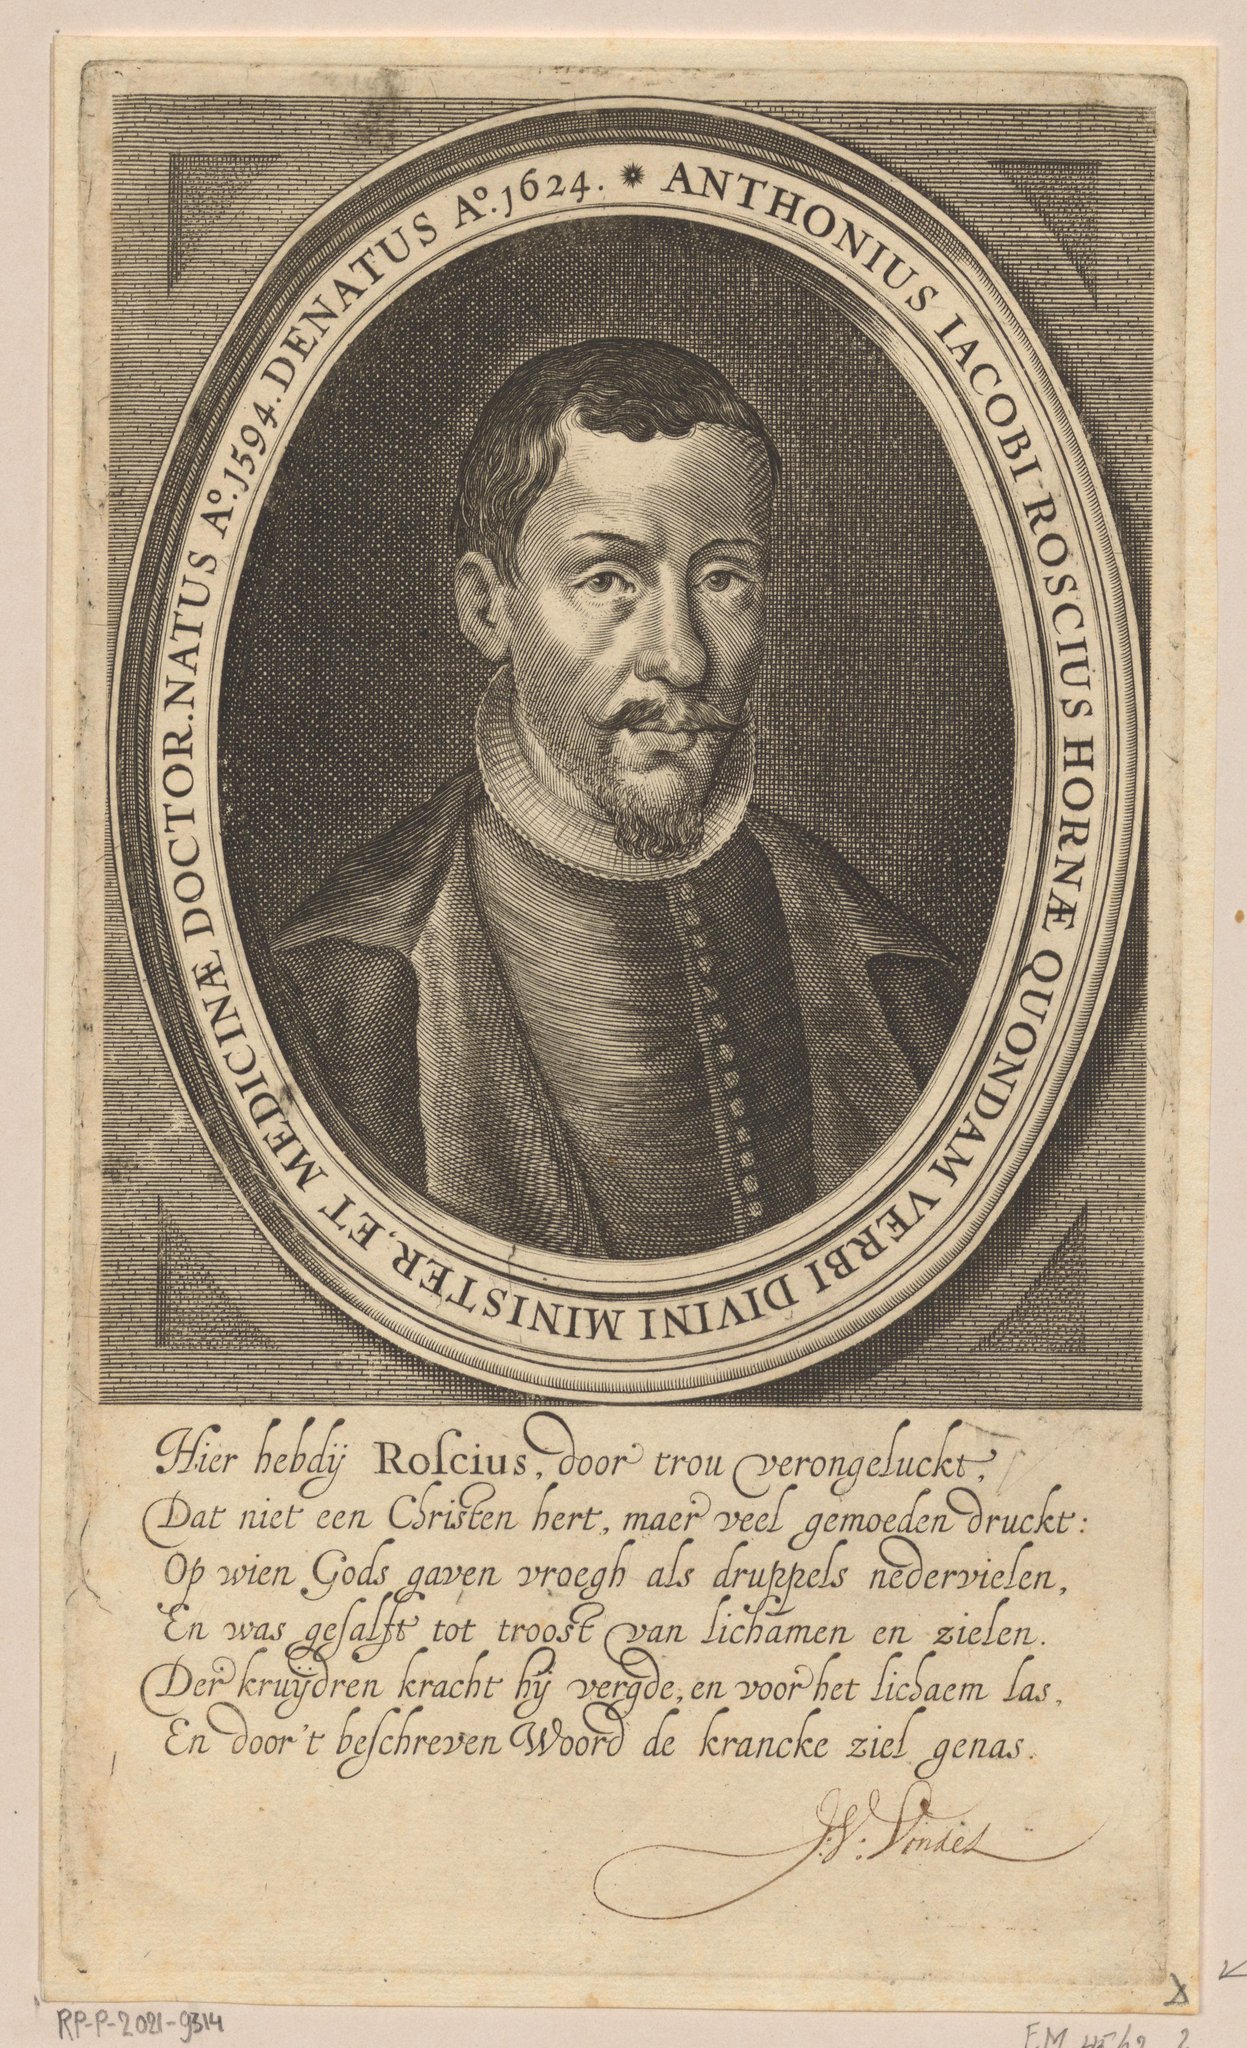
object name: print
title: Portret van Anthoni Jacobi Roscius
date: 1624-1647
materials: paper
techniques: engraving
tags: historical persons